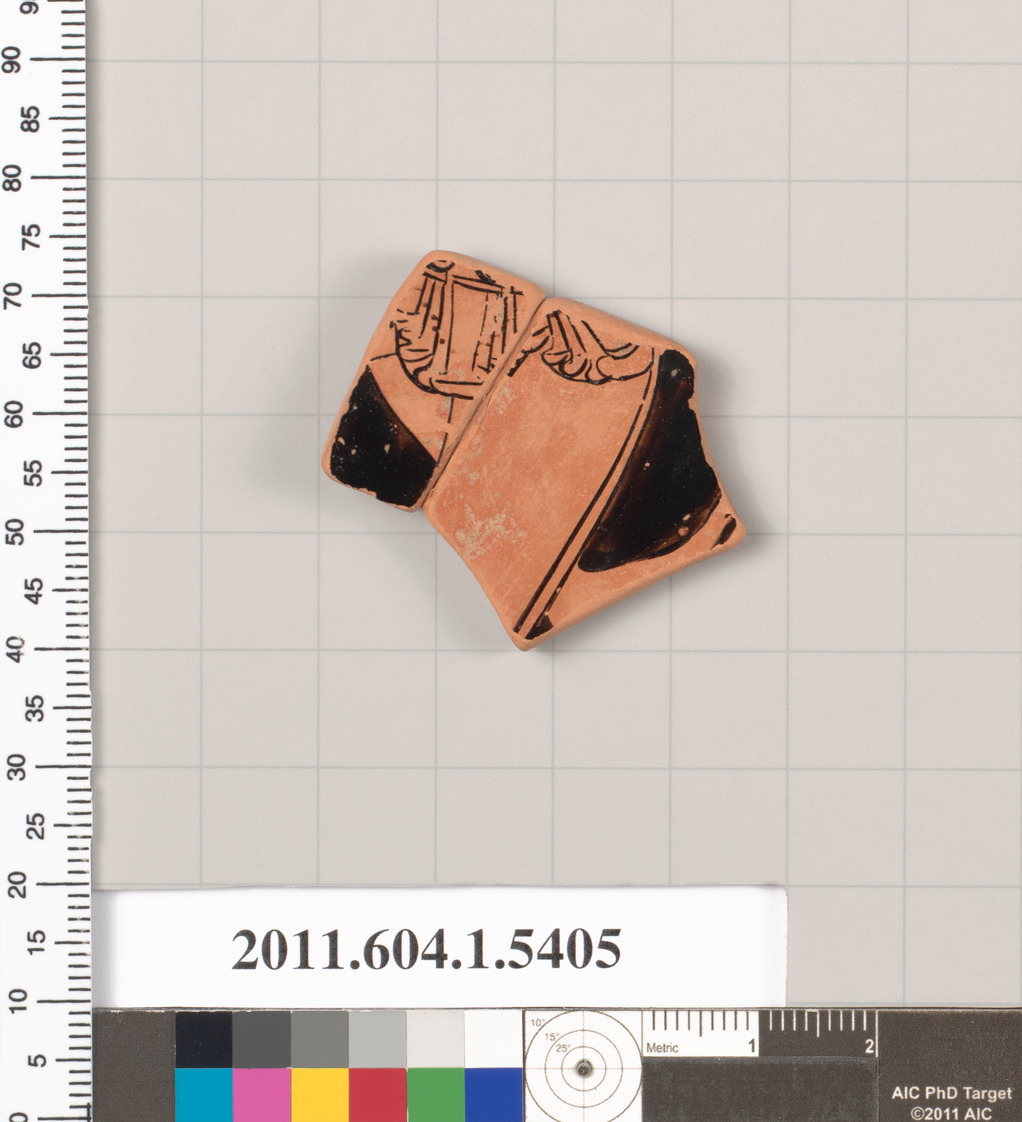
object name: kylix fragment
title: Terracotta fragment of a kylix (drinking cup)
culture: greek, attic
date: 500-490 BCE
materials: terracotta